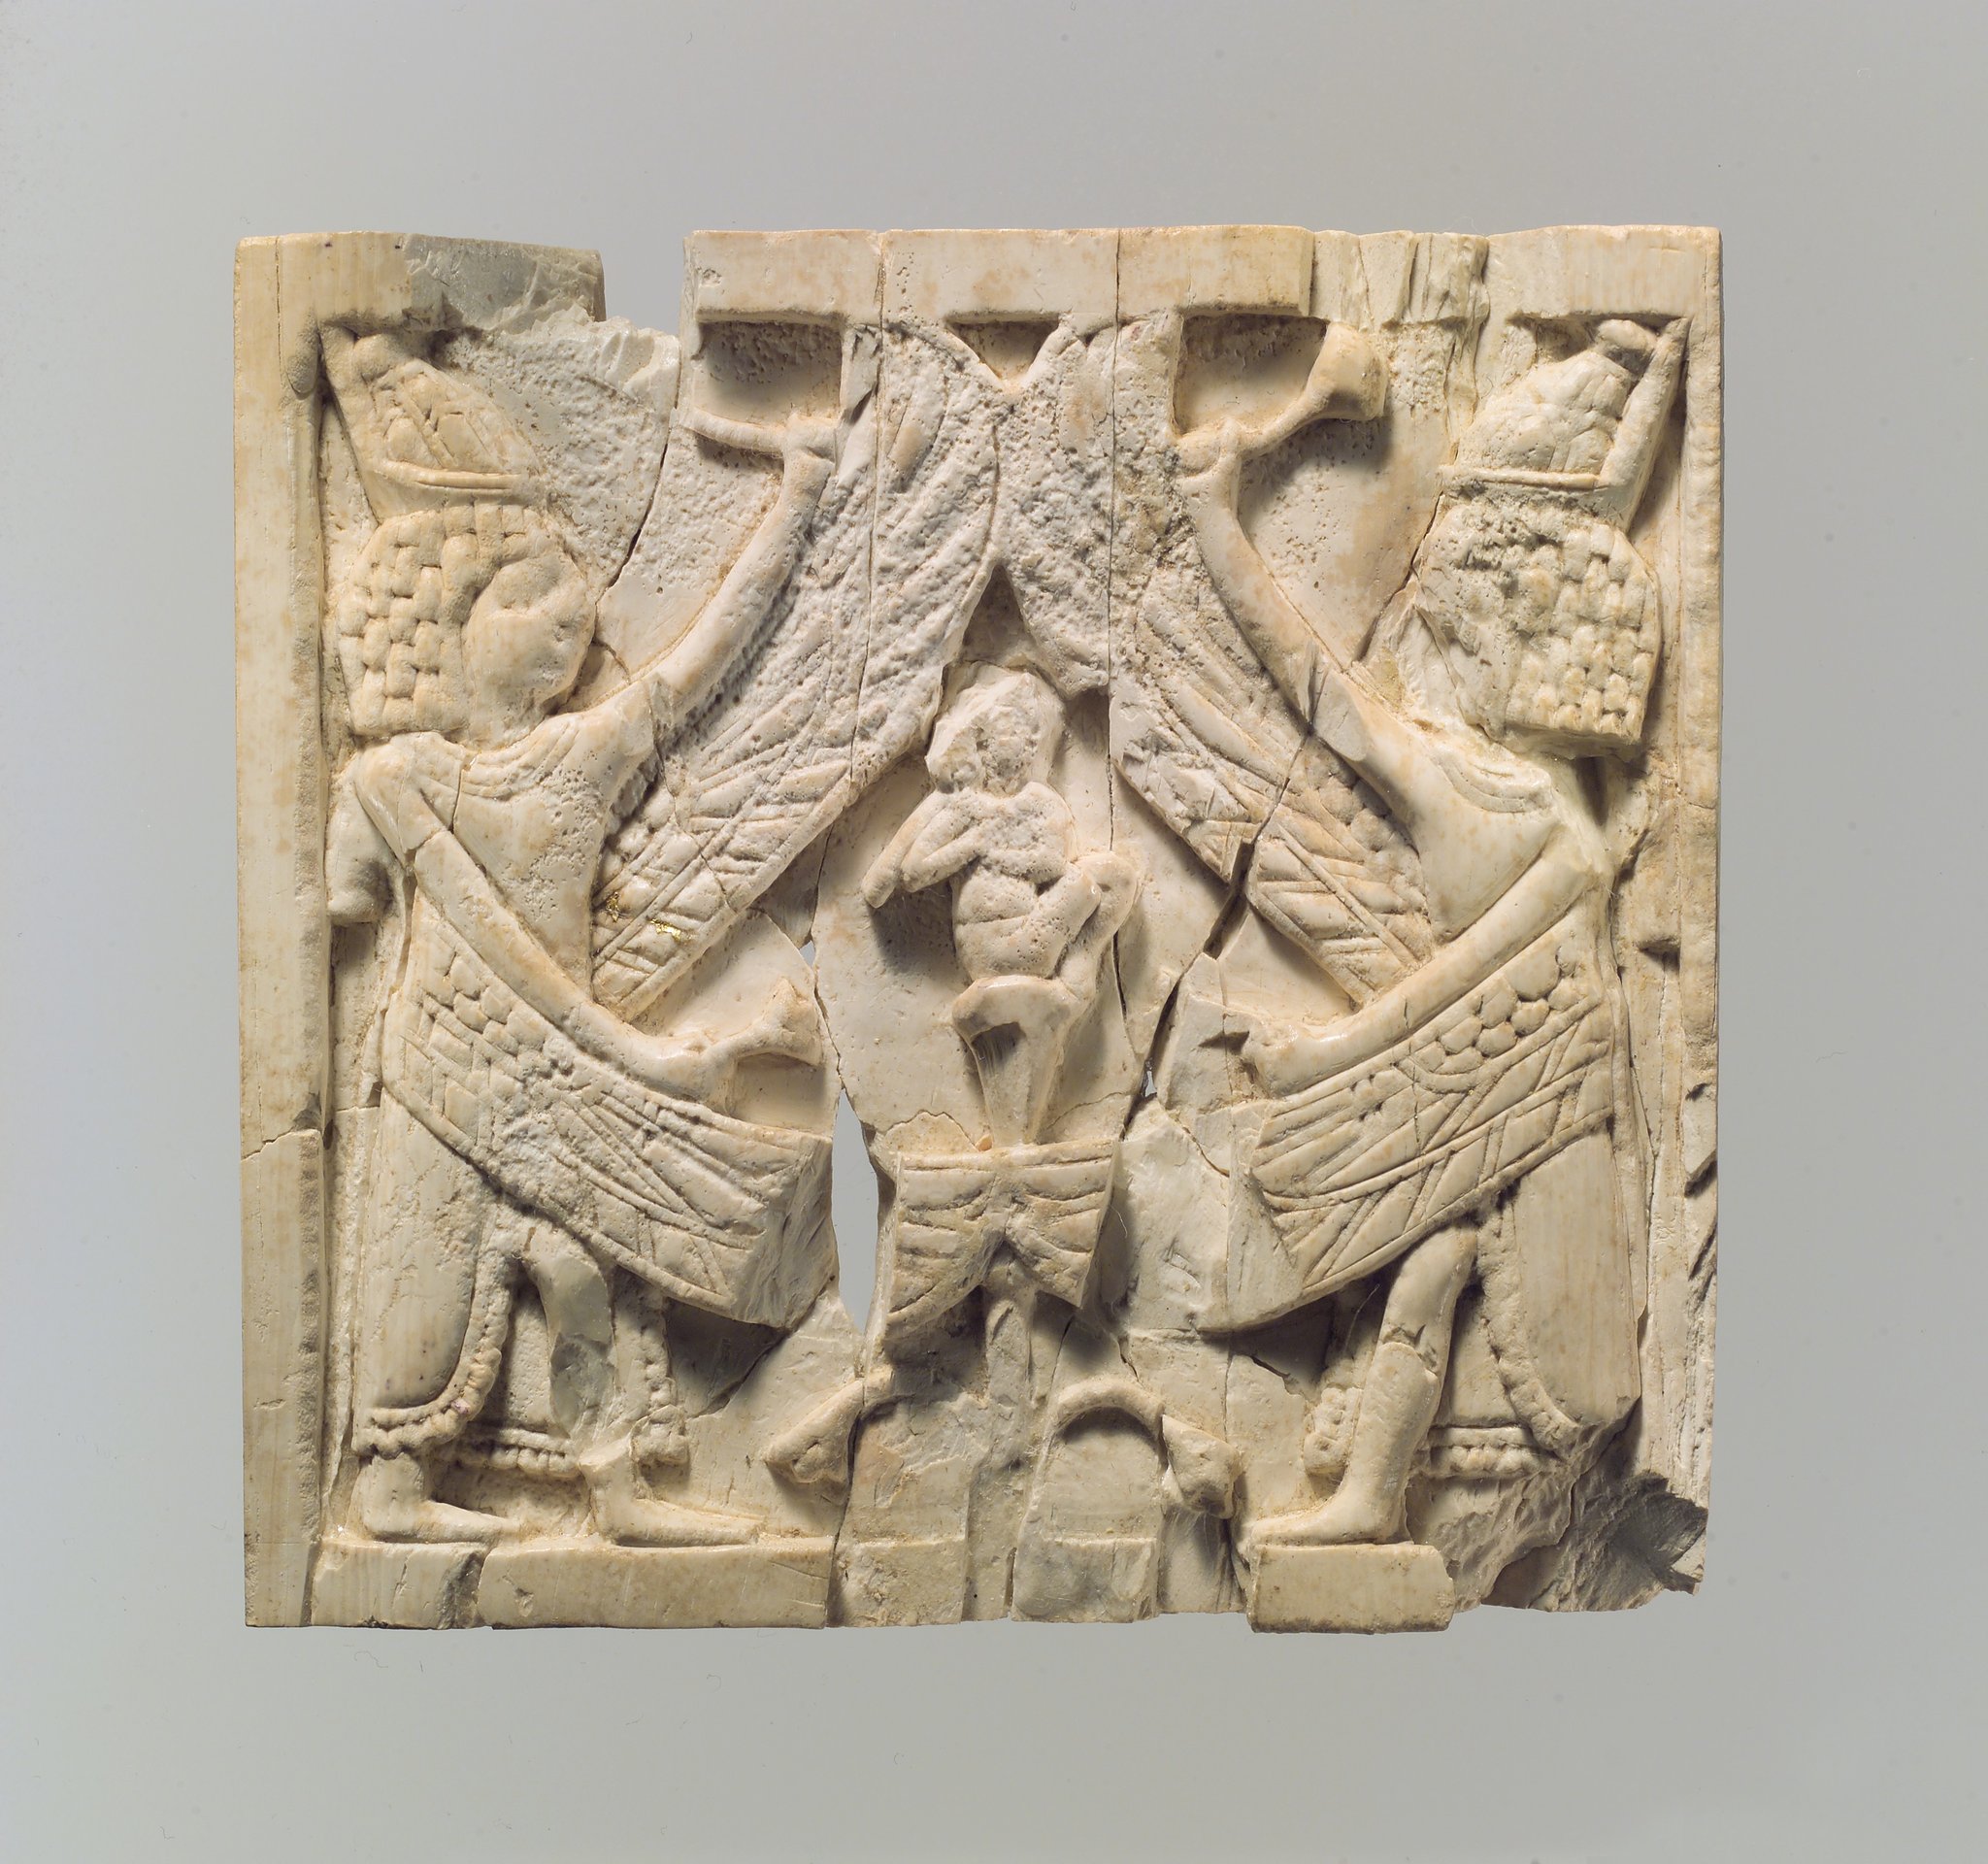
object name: relief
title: Furniture plaque carved in relief showing two winged, male figures flanking an infant on a lotus flower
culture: assyrian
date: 900-701 BCE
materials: ivory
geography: syria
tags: infants